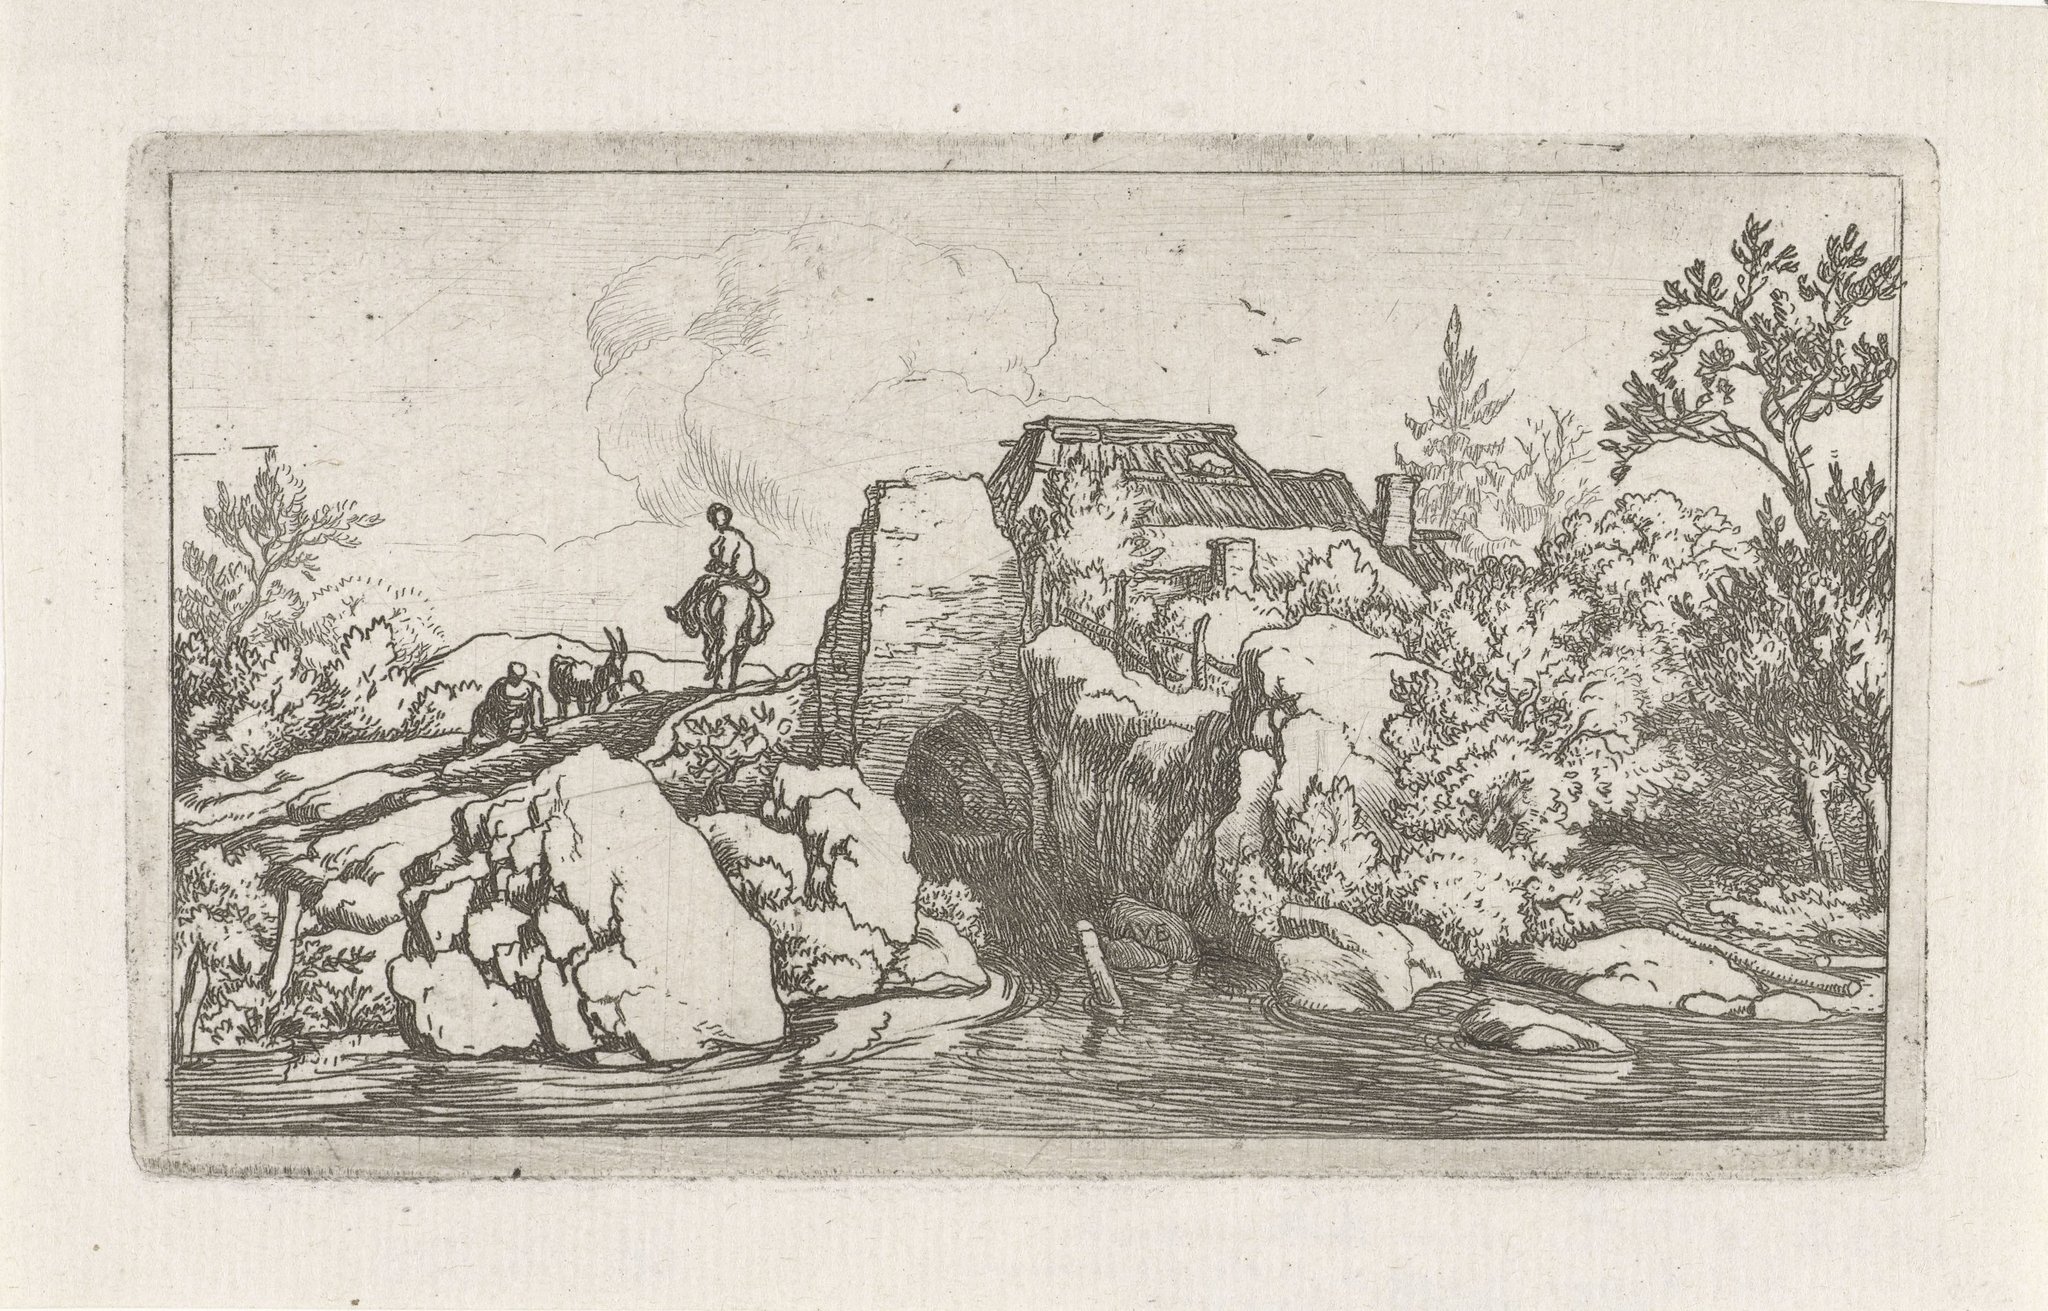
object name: print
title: Ruiter bij stenen brug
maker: allaert van everdingen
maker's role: draughtsman, painter, print maker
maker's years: 1621-1675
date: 1631-1675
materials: paper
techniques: etching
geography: netherlands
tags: landscape with bridge, viaduct or aqueduct - ii - ideal landscapes (+ city(-scape) with figures, staffage)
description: Landschap met waterpartij op de voorgrond. Op het pad over de rivier staat een bok en een persoon op een paard. Aan de overkant van de brug zijn enkele daken zichtbaar.